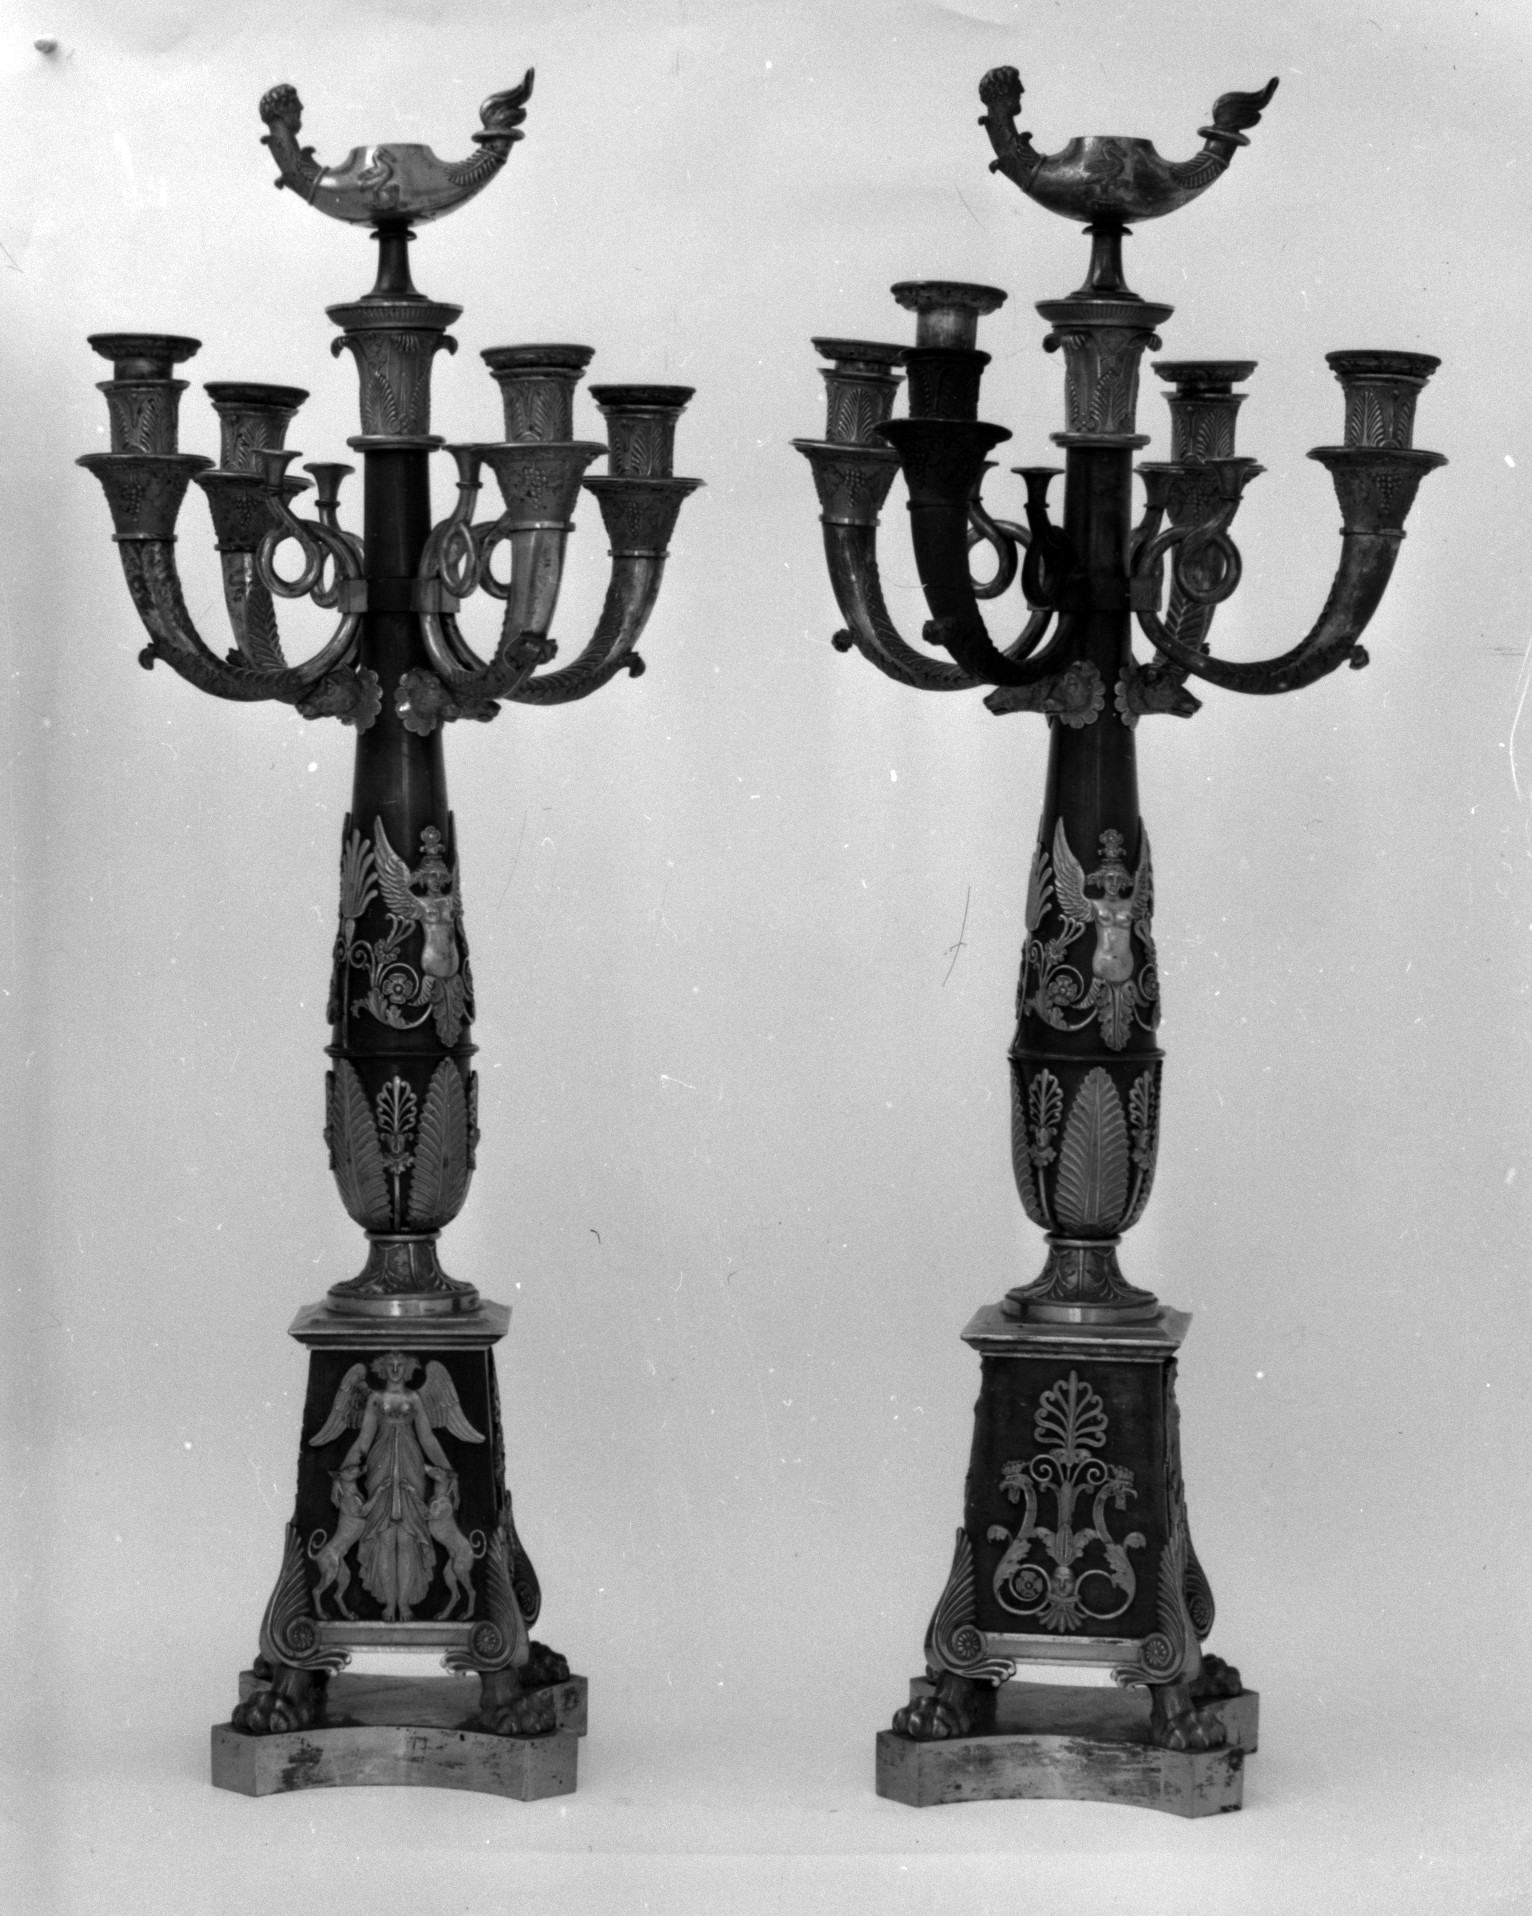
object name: candelabrum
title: Pair of candelabra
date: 1801-1825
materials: bronze, gilt